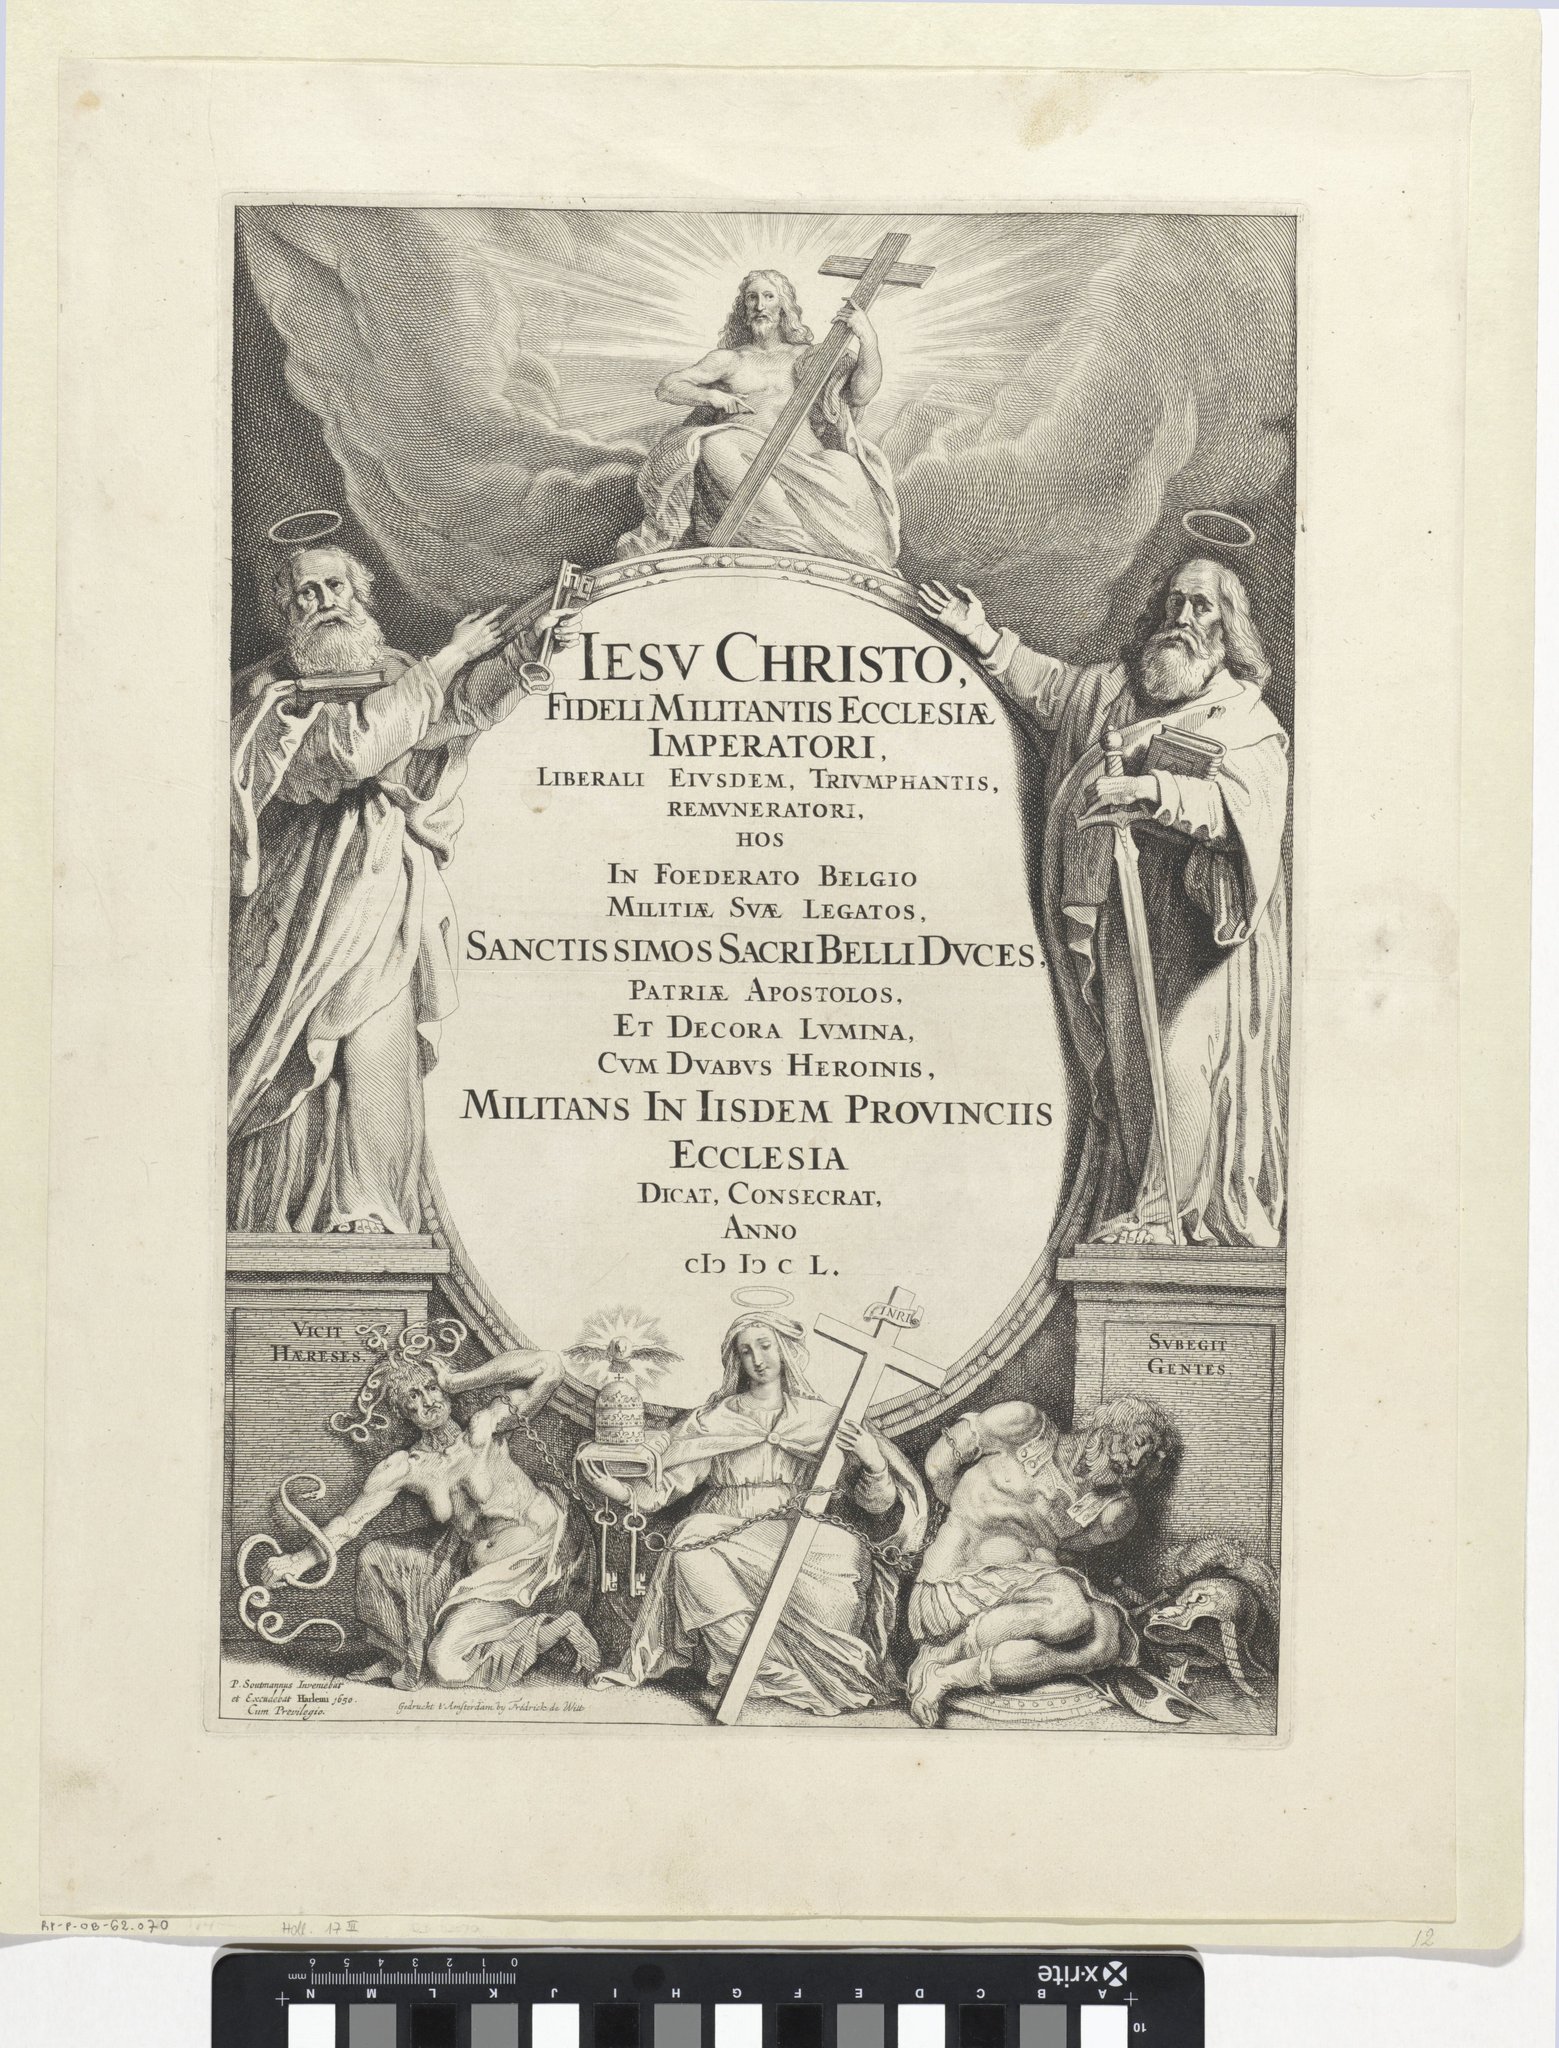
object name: print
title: Iesv Christo, Fideli Militantis Ecclesiae Imperatori, Liberali Eivsdem, Trivmphantis, Remvneratori, hos In Foederato Belgio Militiae Svae Legatos, Sanctissimos Sacri Belli Dvces, Patriae Apostolos, Et Decora Lvmina, Cvm Dvabvs Heroinis, Militans In Iisdem Provinciis Ecclesia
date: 1650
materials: paper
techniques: engraving, etching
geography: amsterdam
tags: fides (faith) as roman personification, christ as adult, symbols, allegories of war; 'guerra' (ripa), invidia (envy) as roman personification, the apostle peter, first bishop of rome; possible attributes: book, cock, (upturned) cross, (triple) crozier, fish, key, scroll, ship, tiara, the apostle paul of tarsus; possible attributes: book, scroll, sword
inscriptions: collector's mark: Lugt 240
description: Titelprent voor de serie: Iesv Christo, Fideli Militantis Ecclesiae Imperatori, Liberali Eivsdem, Trivmphantis, Remvneratori, hos In Foederato Belgio Militiae Svae Legatos, Sanctissimos Sacri Belli Dvces, Patriae Apostolos, Et Decora Lvmina, Cvm Dvabvs Heroinis, Militans In Iisdem Provinciis Ecclesia. Haarlem: Pieter Claesz. Soutman, 1650.